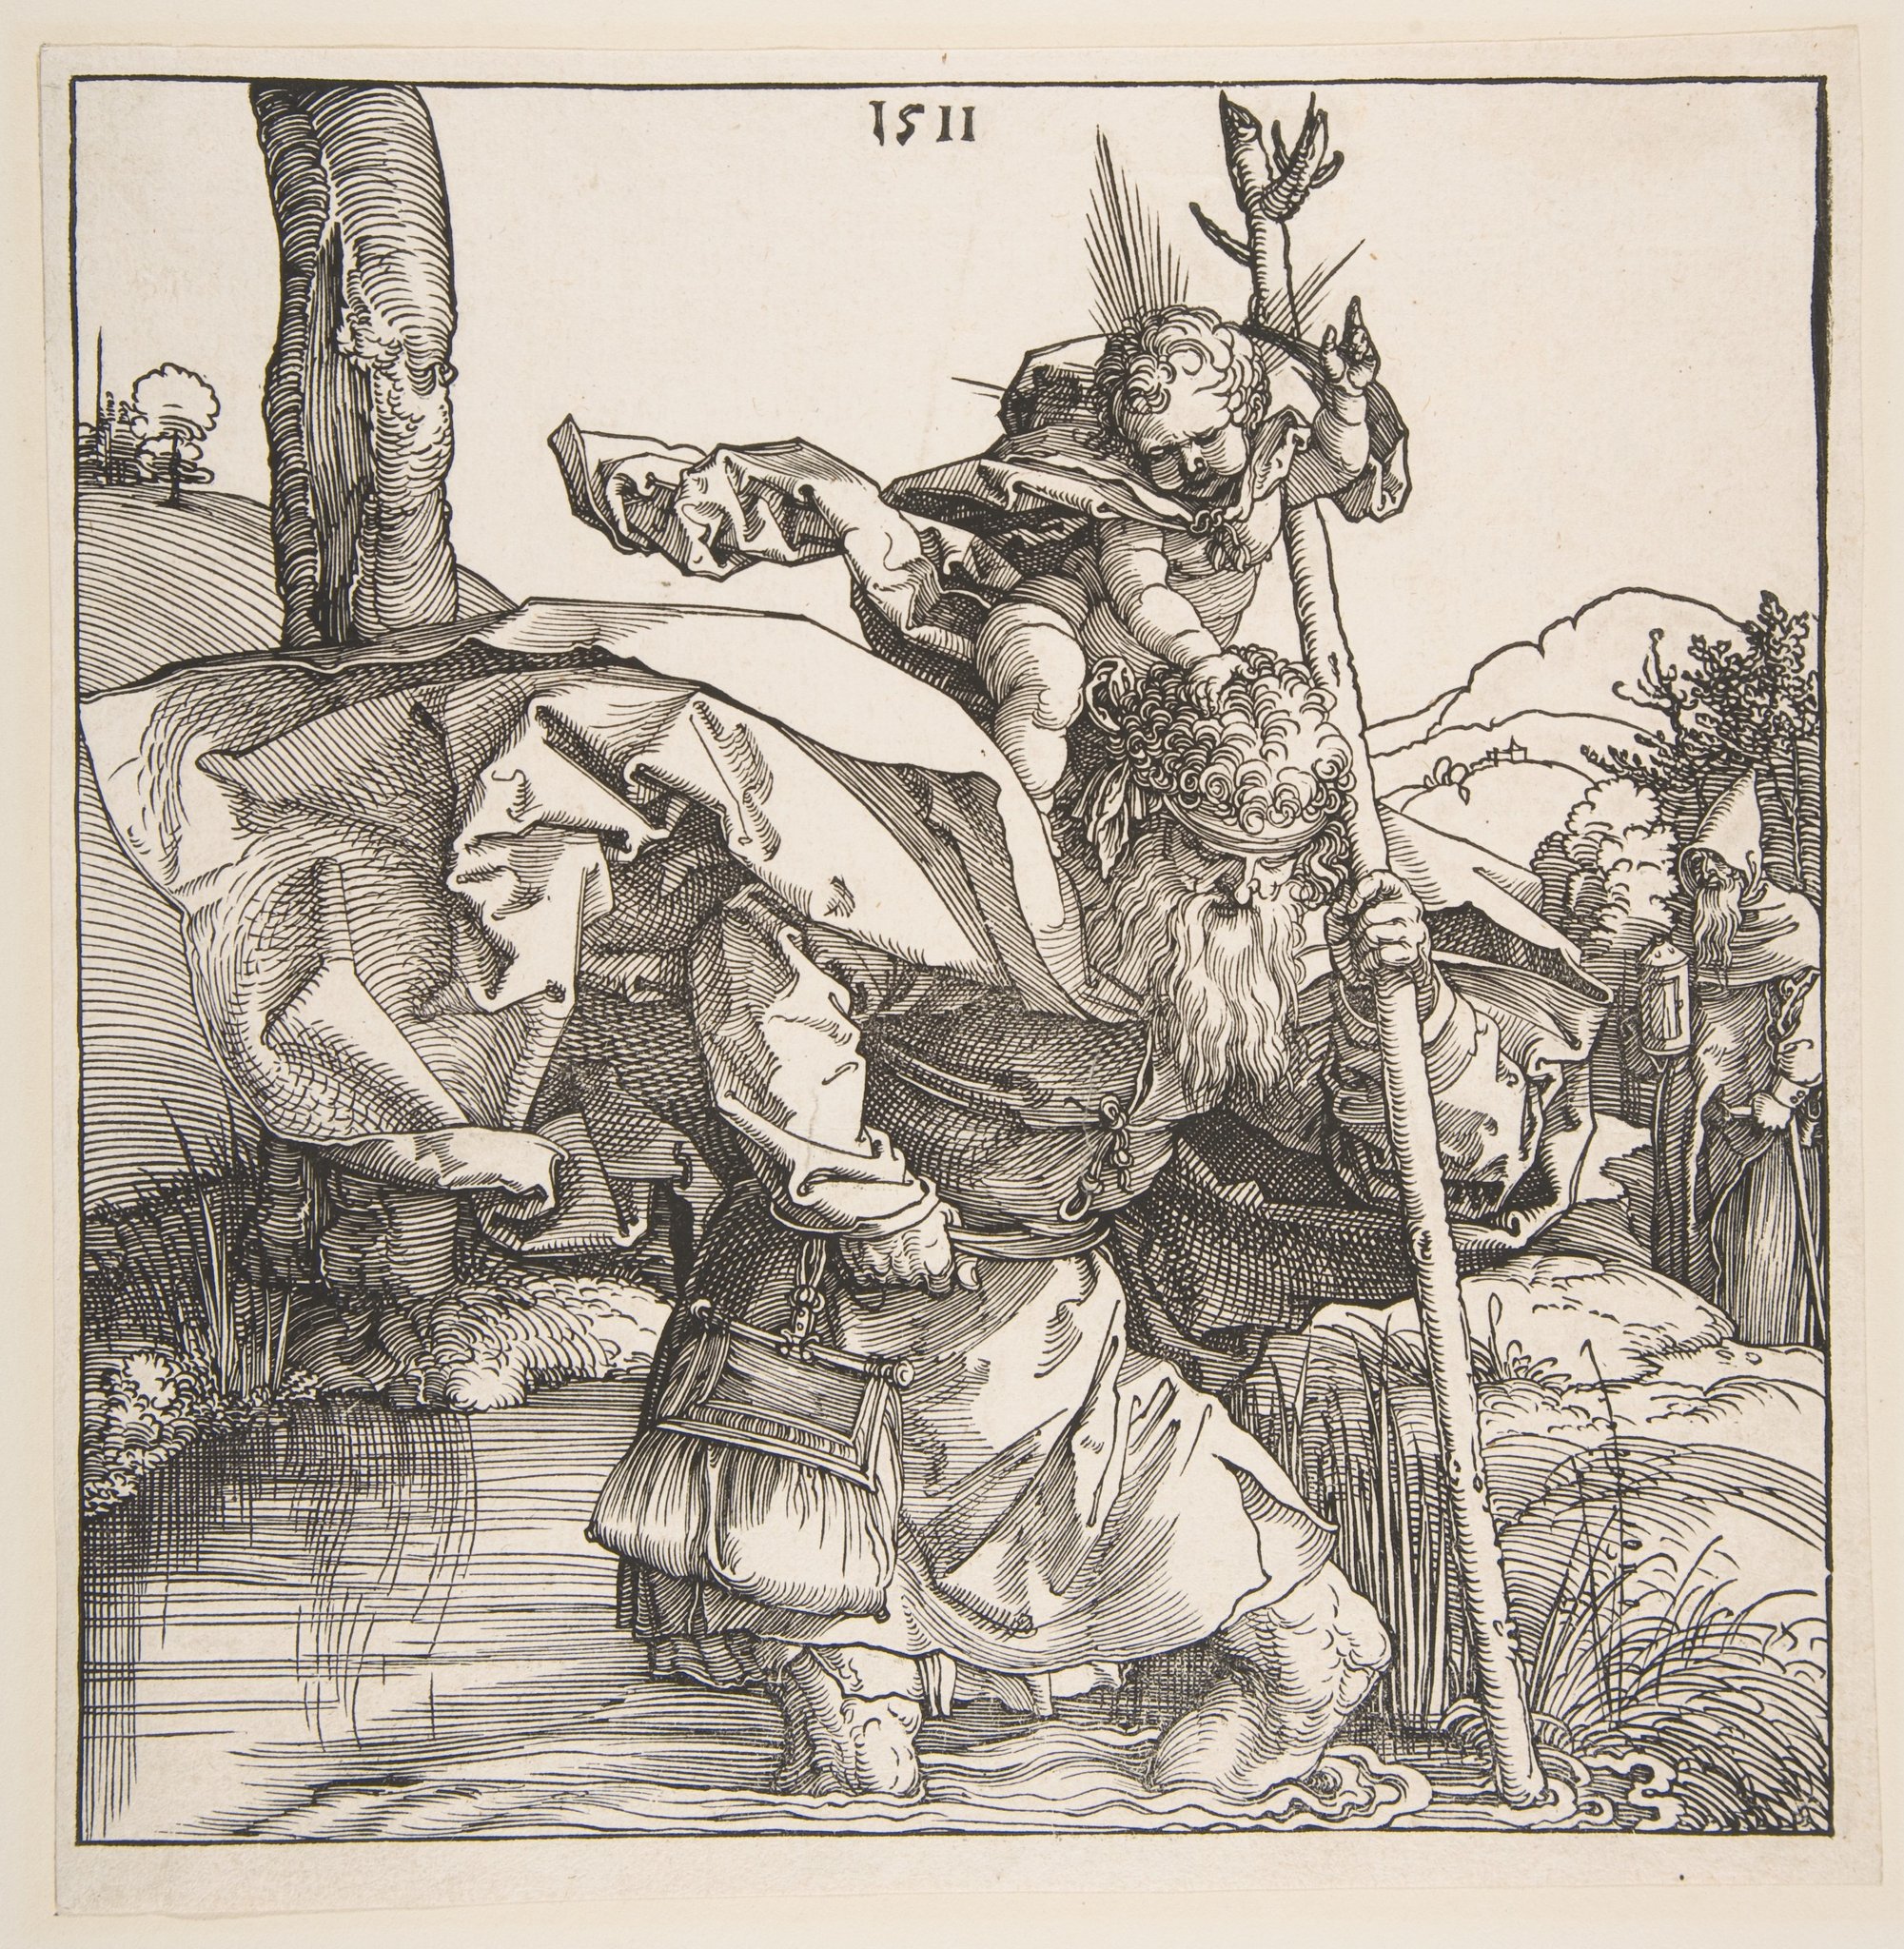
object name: print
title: Saint Christopher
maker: albrecht dürer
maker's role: artist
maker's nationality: german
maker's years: 1471-1528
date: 1511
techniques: woodcut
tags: men,christ,saint christopher